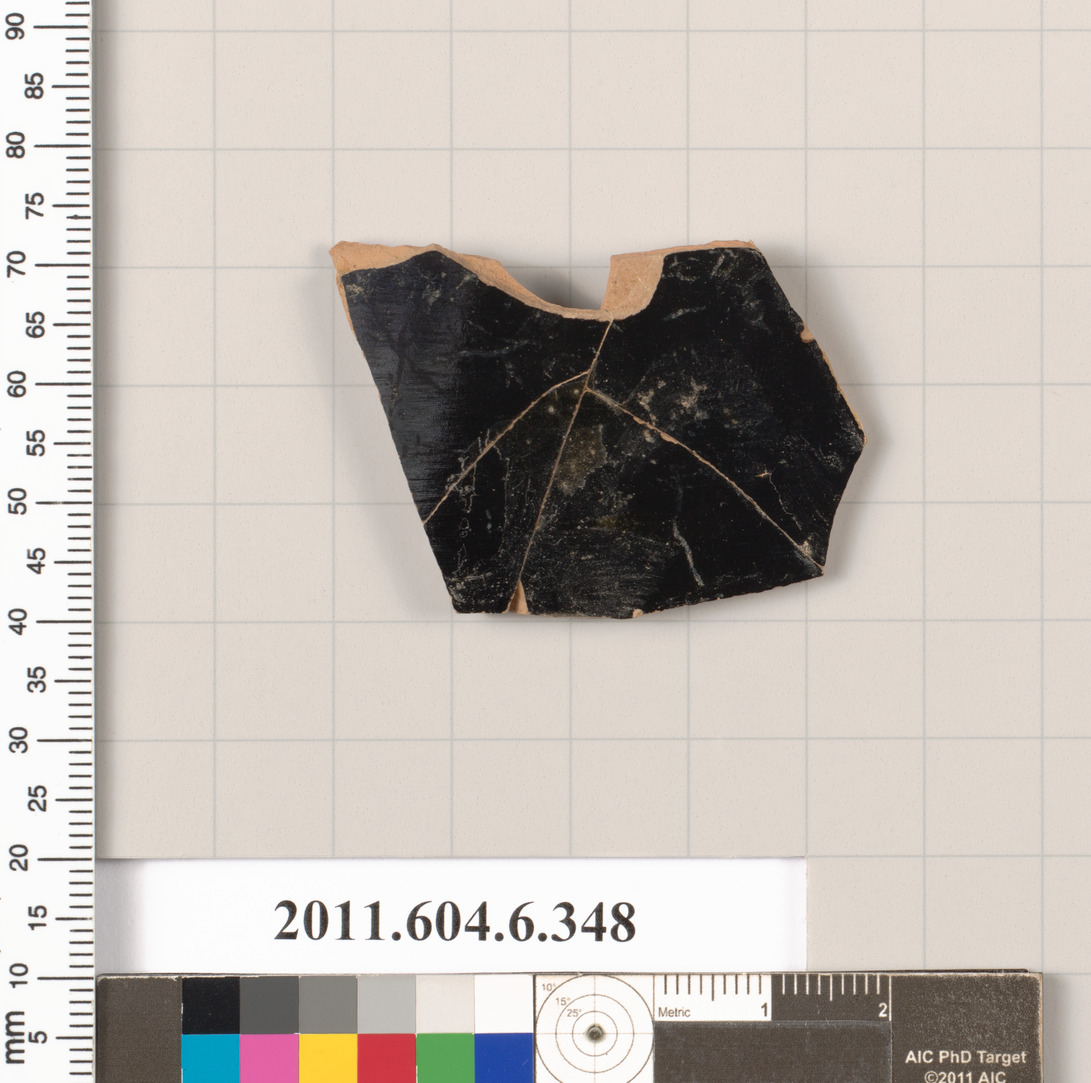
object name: undetermined closed shape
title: Terracotta fragment of a closed shape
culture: greek, attic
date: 600-401 BCE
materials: terracotta